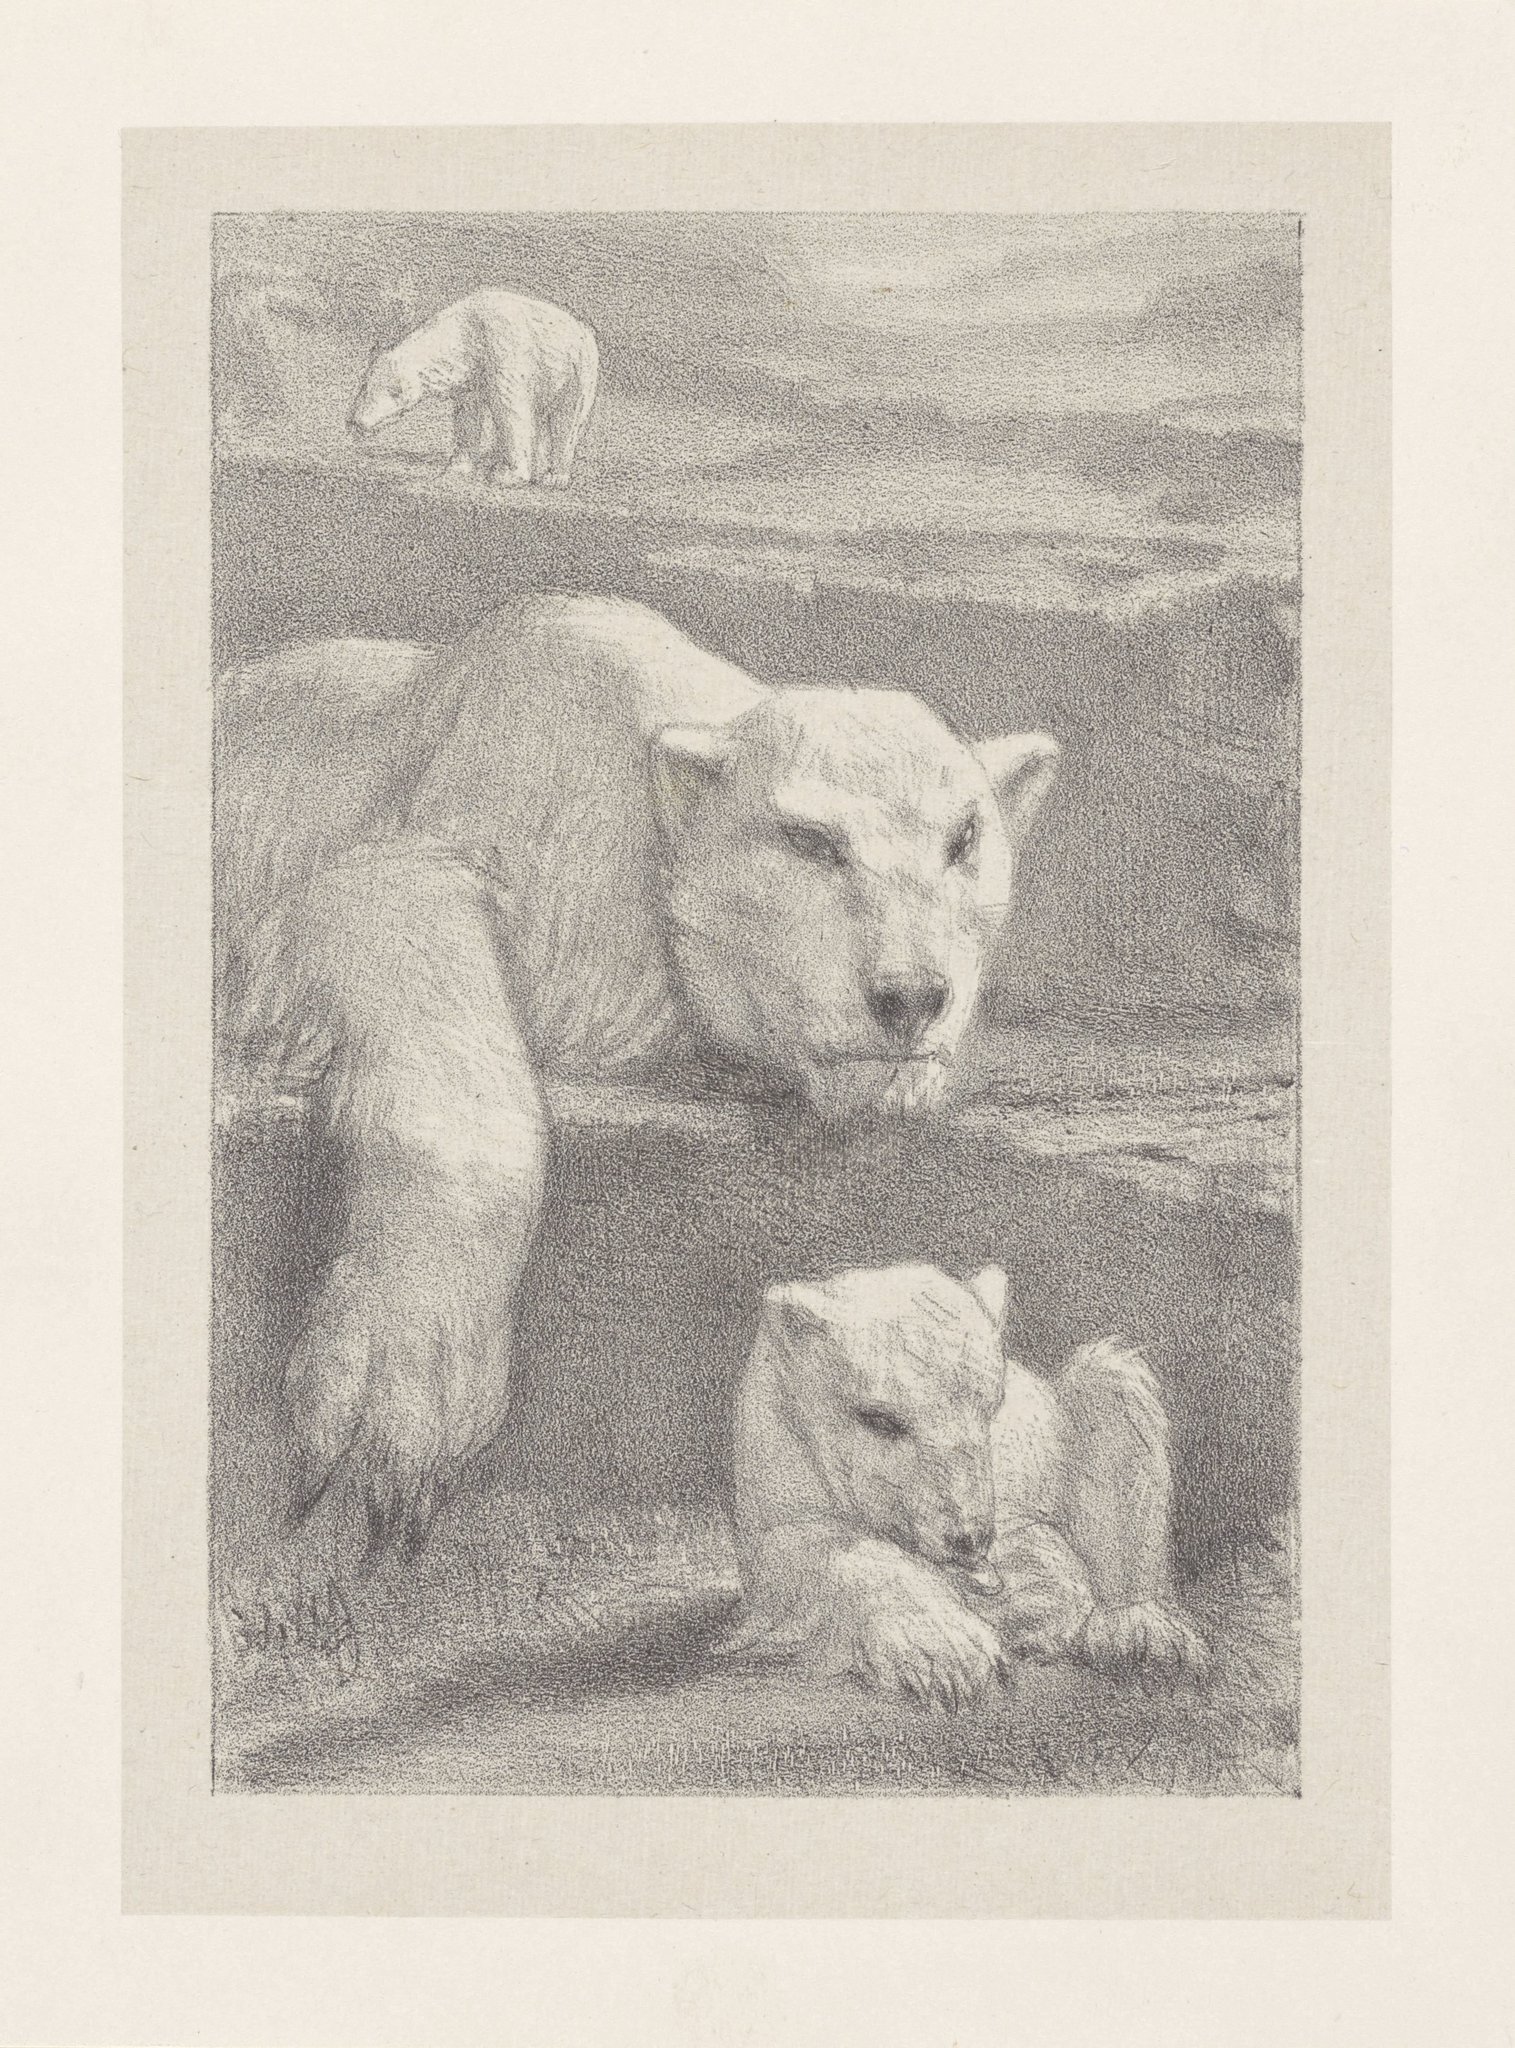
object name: print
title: Drie ijsberen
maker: august allebé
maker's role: draughtsman, print maker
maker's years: 1838-1927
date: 1848-1909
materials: paper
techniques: lithography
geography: amsterdam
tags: beasts of prey, predatory animals: polar bear, beasts of prey, predatory animals: bear (+ feeding and care of young)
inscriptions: collector's mark: Lugt 2228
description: Een ijsbeerjong likt aan zijn poot. Op een rots ligt, half zichtbaar, een volwassen ijsbeer. In de achtergrond staat een derde ijsbeer.